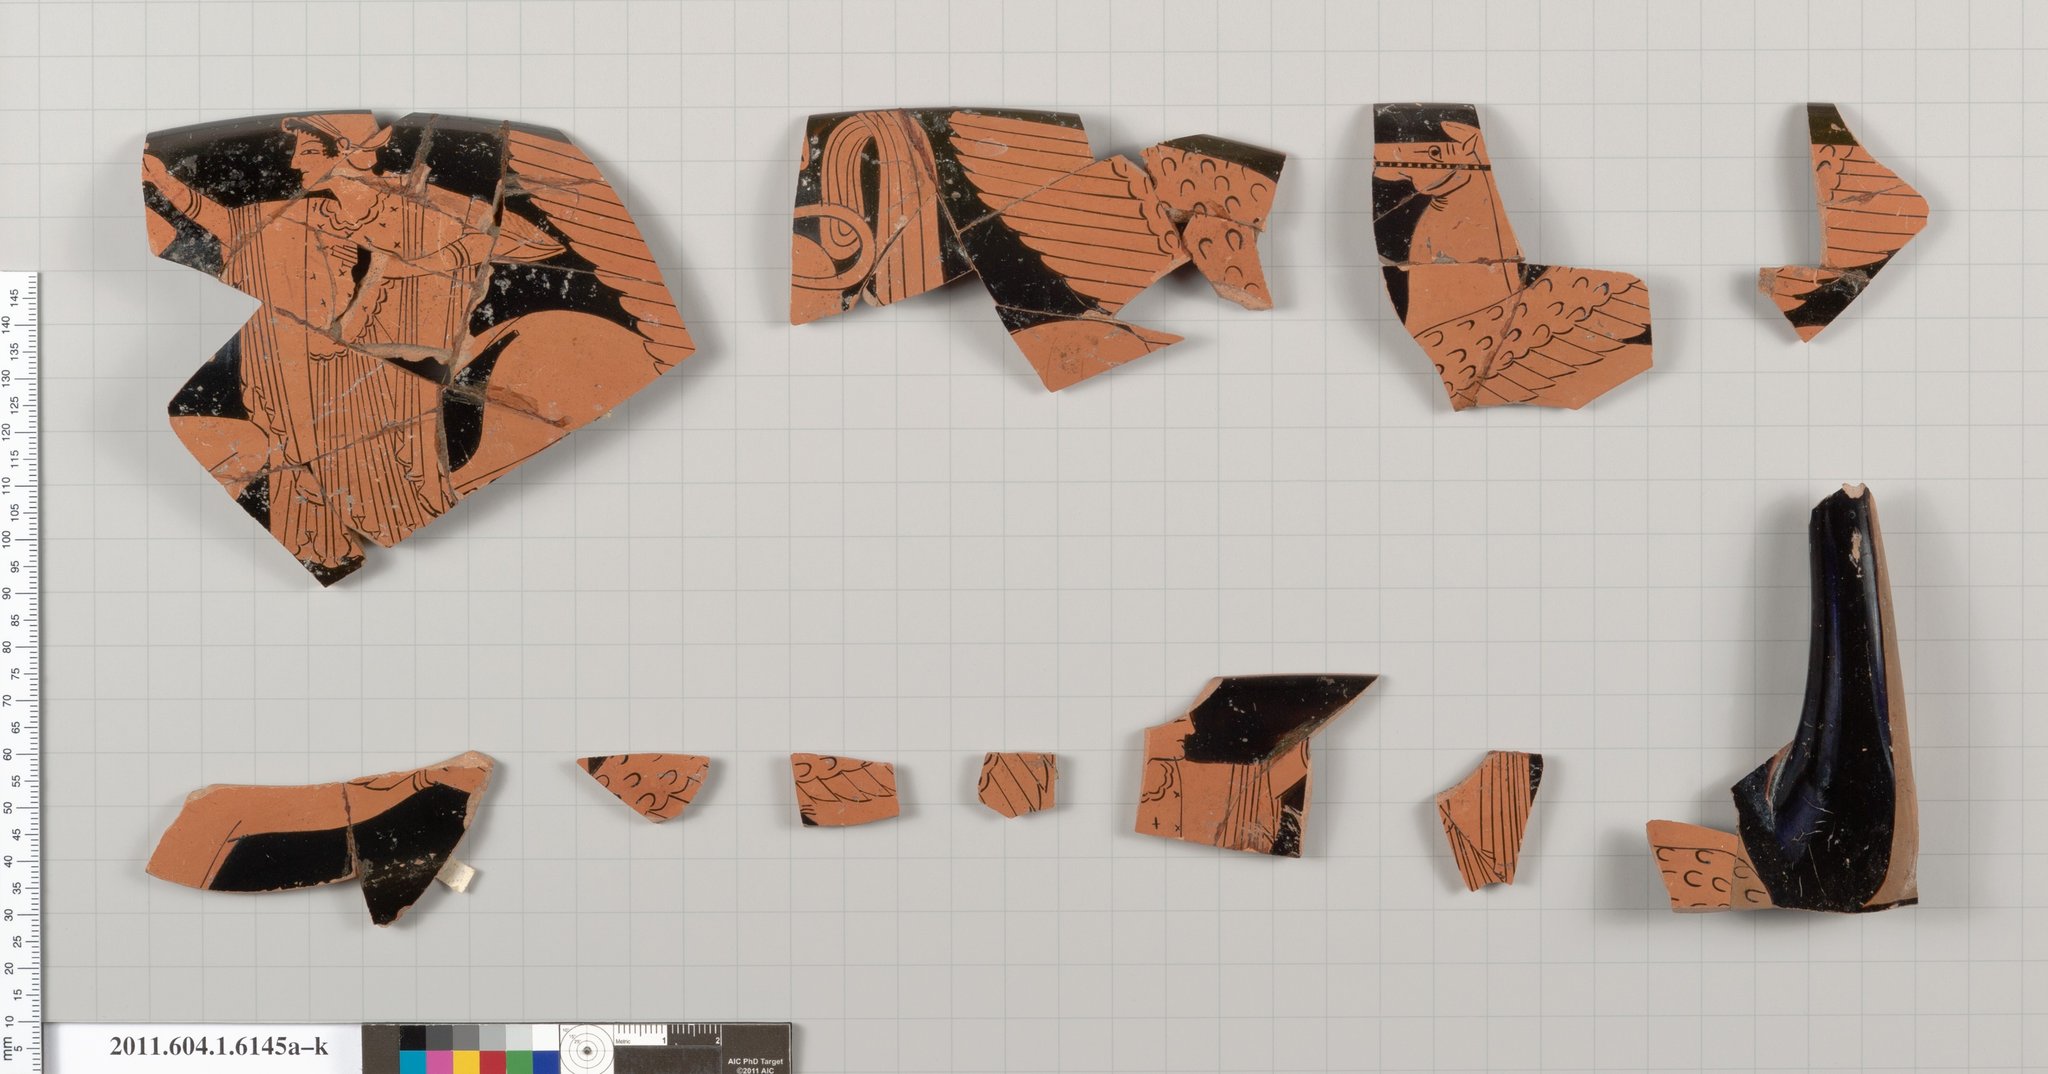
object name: kylix fragment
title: Terracotta fragments of a kylix (drinking cup)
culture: greek, attic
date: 520-500 BCE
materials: terracotta